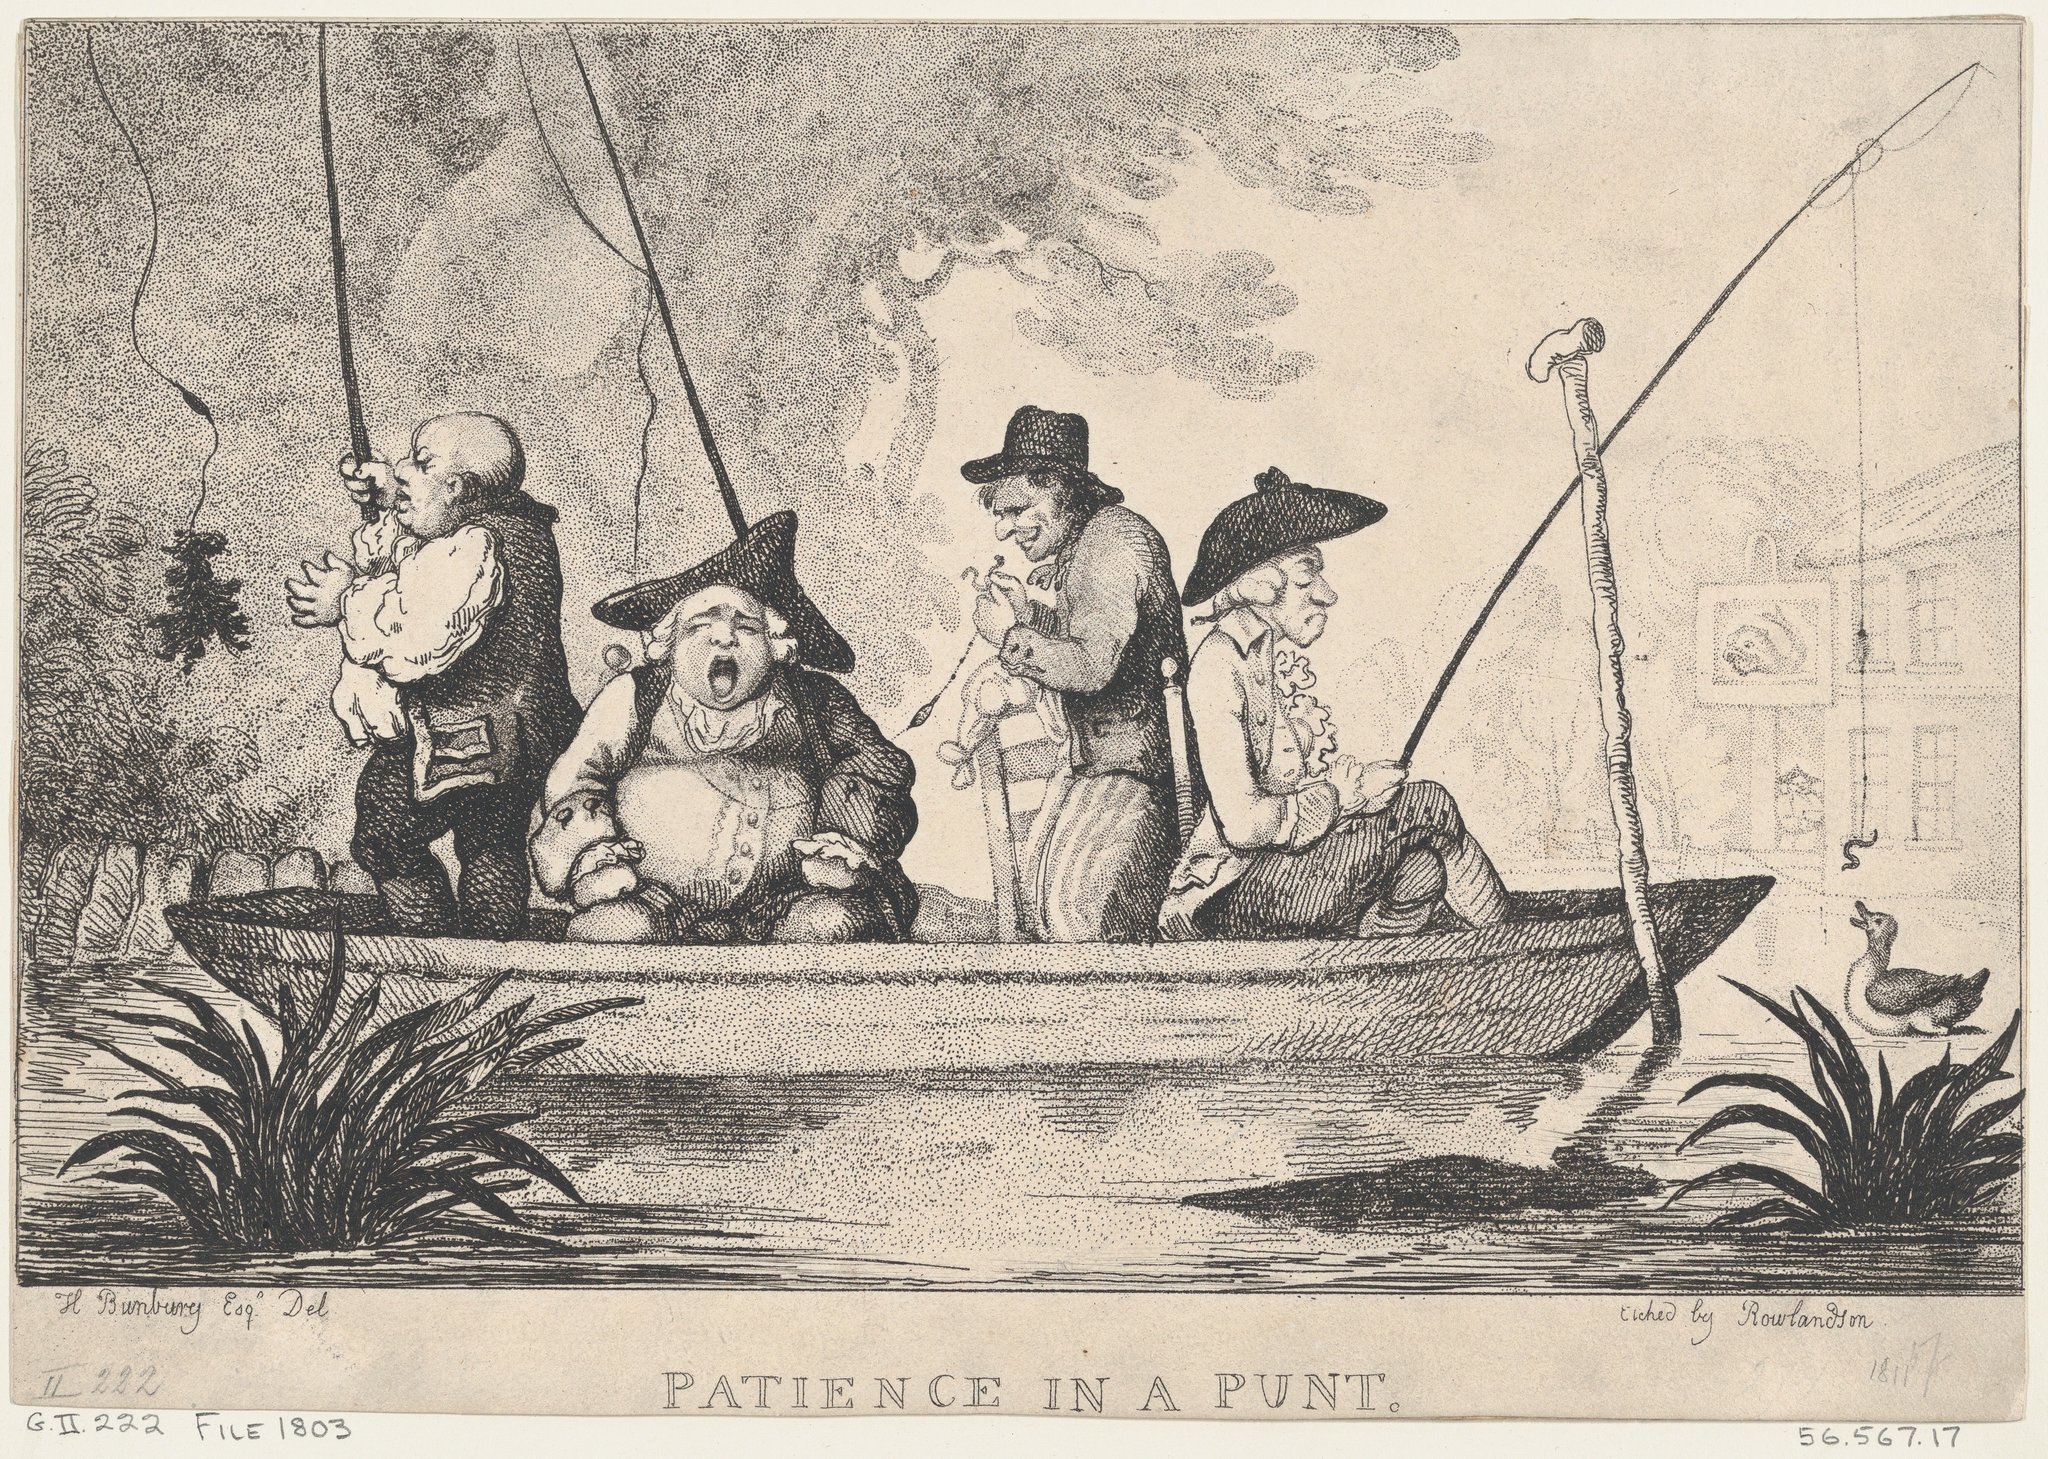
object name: print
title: Patience in a Punt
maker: thomas rowlandson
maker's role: artist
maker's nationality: british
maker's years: 1757-1827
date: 1803-1811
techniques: etching, stippling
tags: ducks,satire,men,fishing,boats